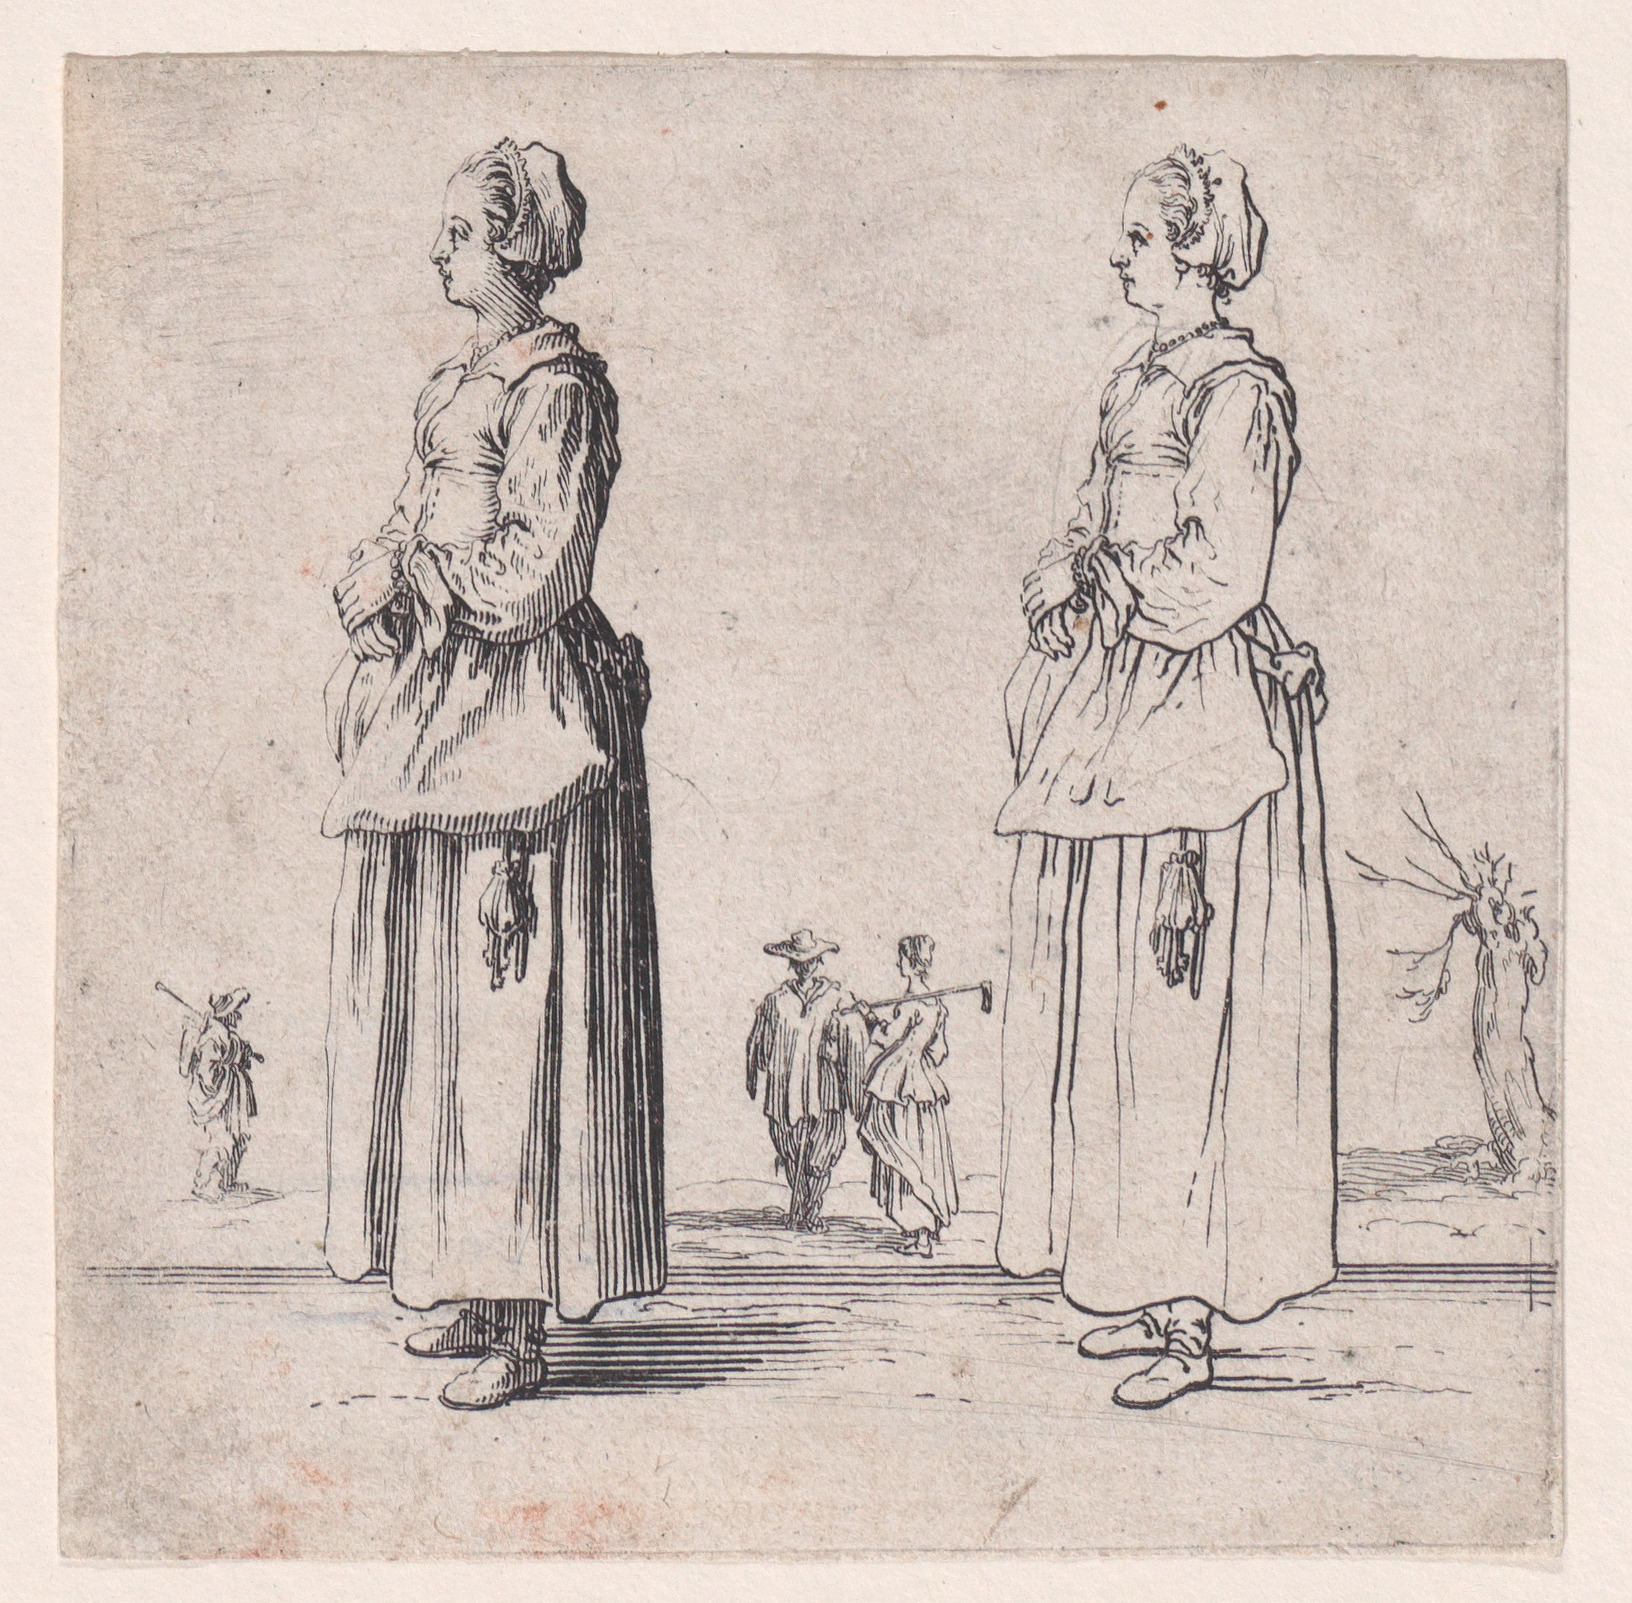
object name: print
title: La Paysanne Tournée a Gauche, les Mains Appuyées l'Une sur l'Autre (The Peasant Woman Turned to the Left, One Hand Placed in the Other), from "Varie Figure" (Various Figures)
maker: jacques callot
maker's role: artist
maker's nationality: french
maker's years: 1592-1635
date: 1620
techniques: etching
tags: women